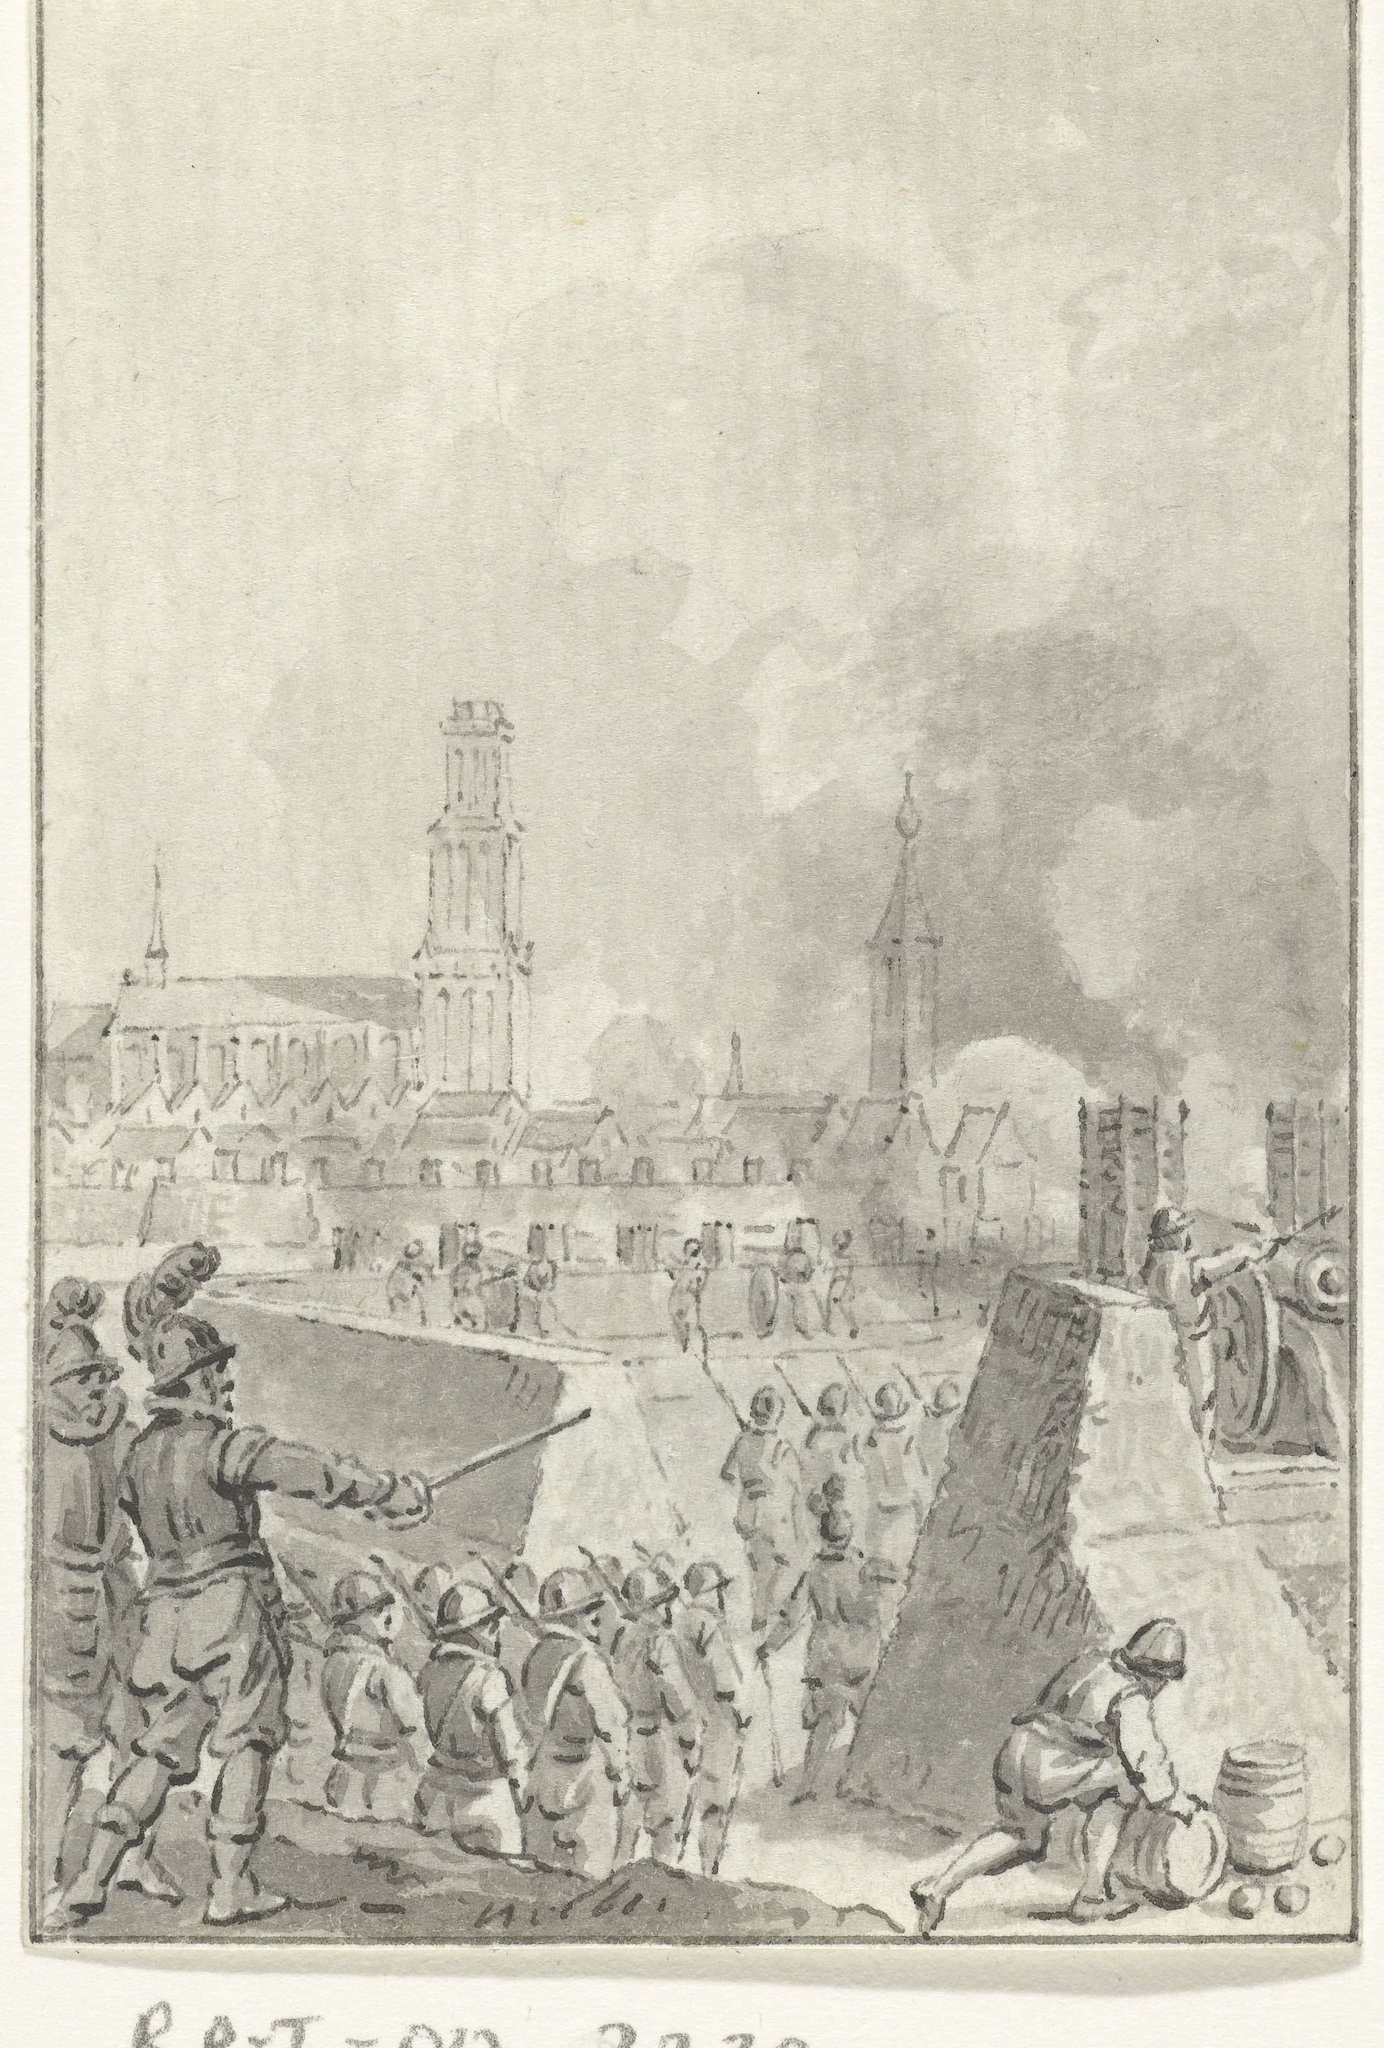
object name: design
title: Beleg van Zaltbommel, 1599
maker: jacobus buys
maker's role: draughtsman, print maker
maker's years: 1724-1801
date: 1780-1795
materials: ink, paper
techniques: brush, pen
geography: northern netherlands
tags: the hague, maurice (prince of orange), siege, historical events and situations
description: Ontwerptekening voor illustratie in: J. Fokke, Geschiedenissen der Vereenigde Nederlanden voor de vaderlandsche jeugd, Johannes Allart, Amsterdam 1783-1795, 25 delen, dl. VI, pl. V. Niet in Frederik Muller; door het RPK toegevoegd nummer.